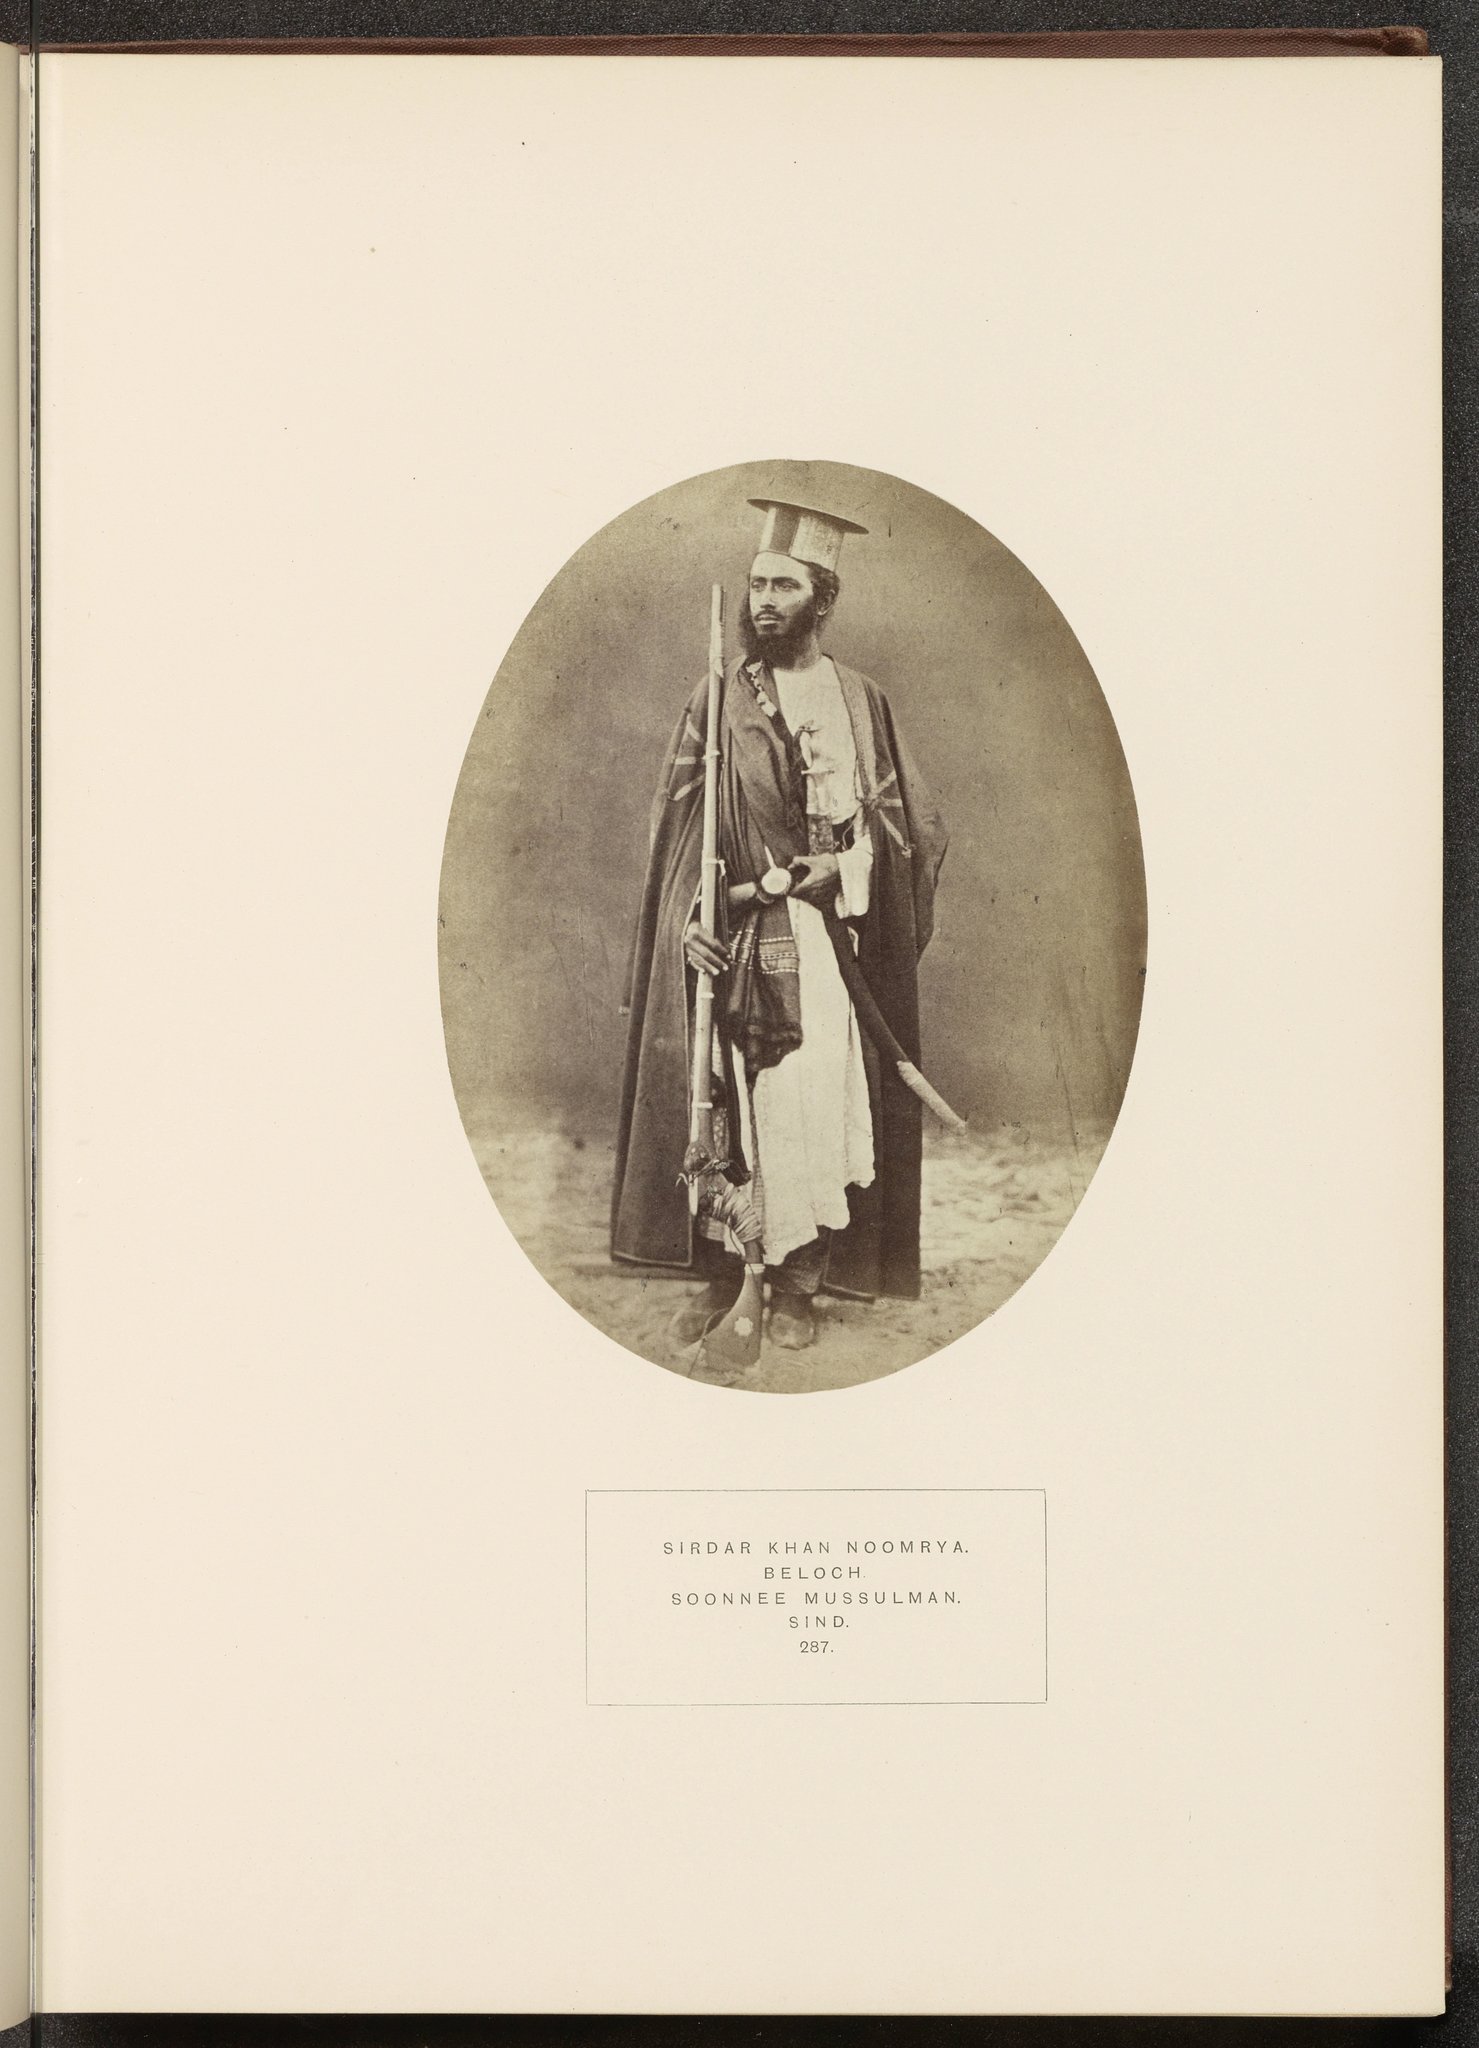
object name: page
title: Portrait of Sirdar Khan with a musket and a sabre, Sindh, Pakistan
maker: henry charles baskerville tanner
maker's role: fotograaf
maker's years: 1835-1898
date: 1862-1872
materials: photographic support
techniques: albumen print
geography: sindh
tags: hacking and thrusting weapons (with name), head-gear: hat, firearms: rifle, ruler, sovereign, human races; peoples; nationalities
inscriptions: number: ‘287.’, inscription: ‘SIRDAR KHAN NOOMRYA./ BELOCH./ SOONNEE MUSSULMAN./ SIND.’